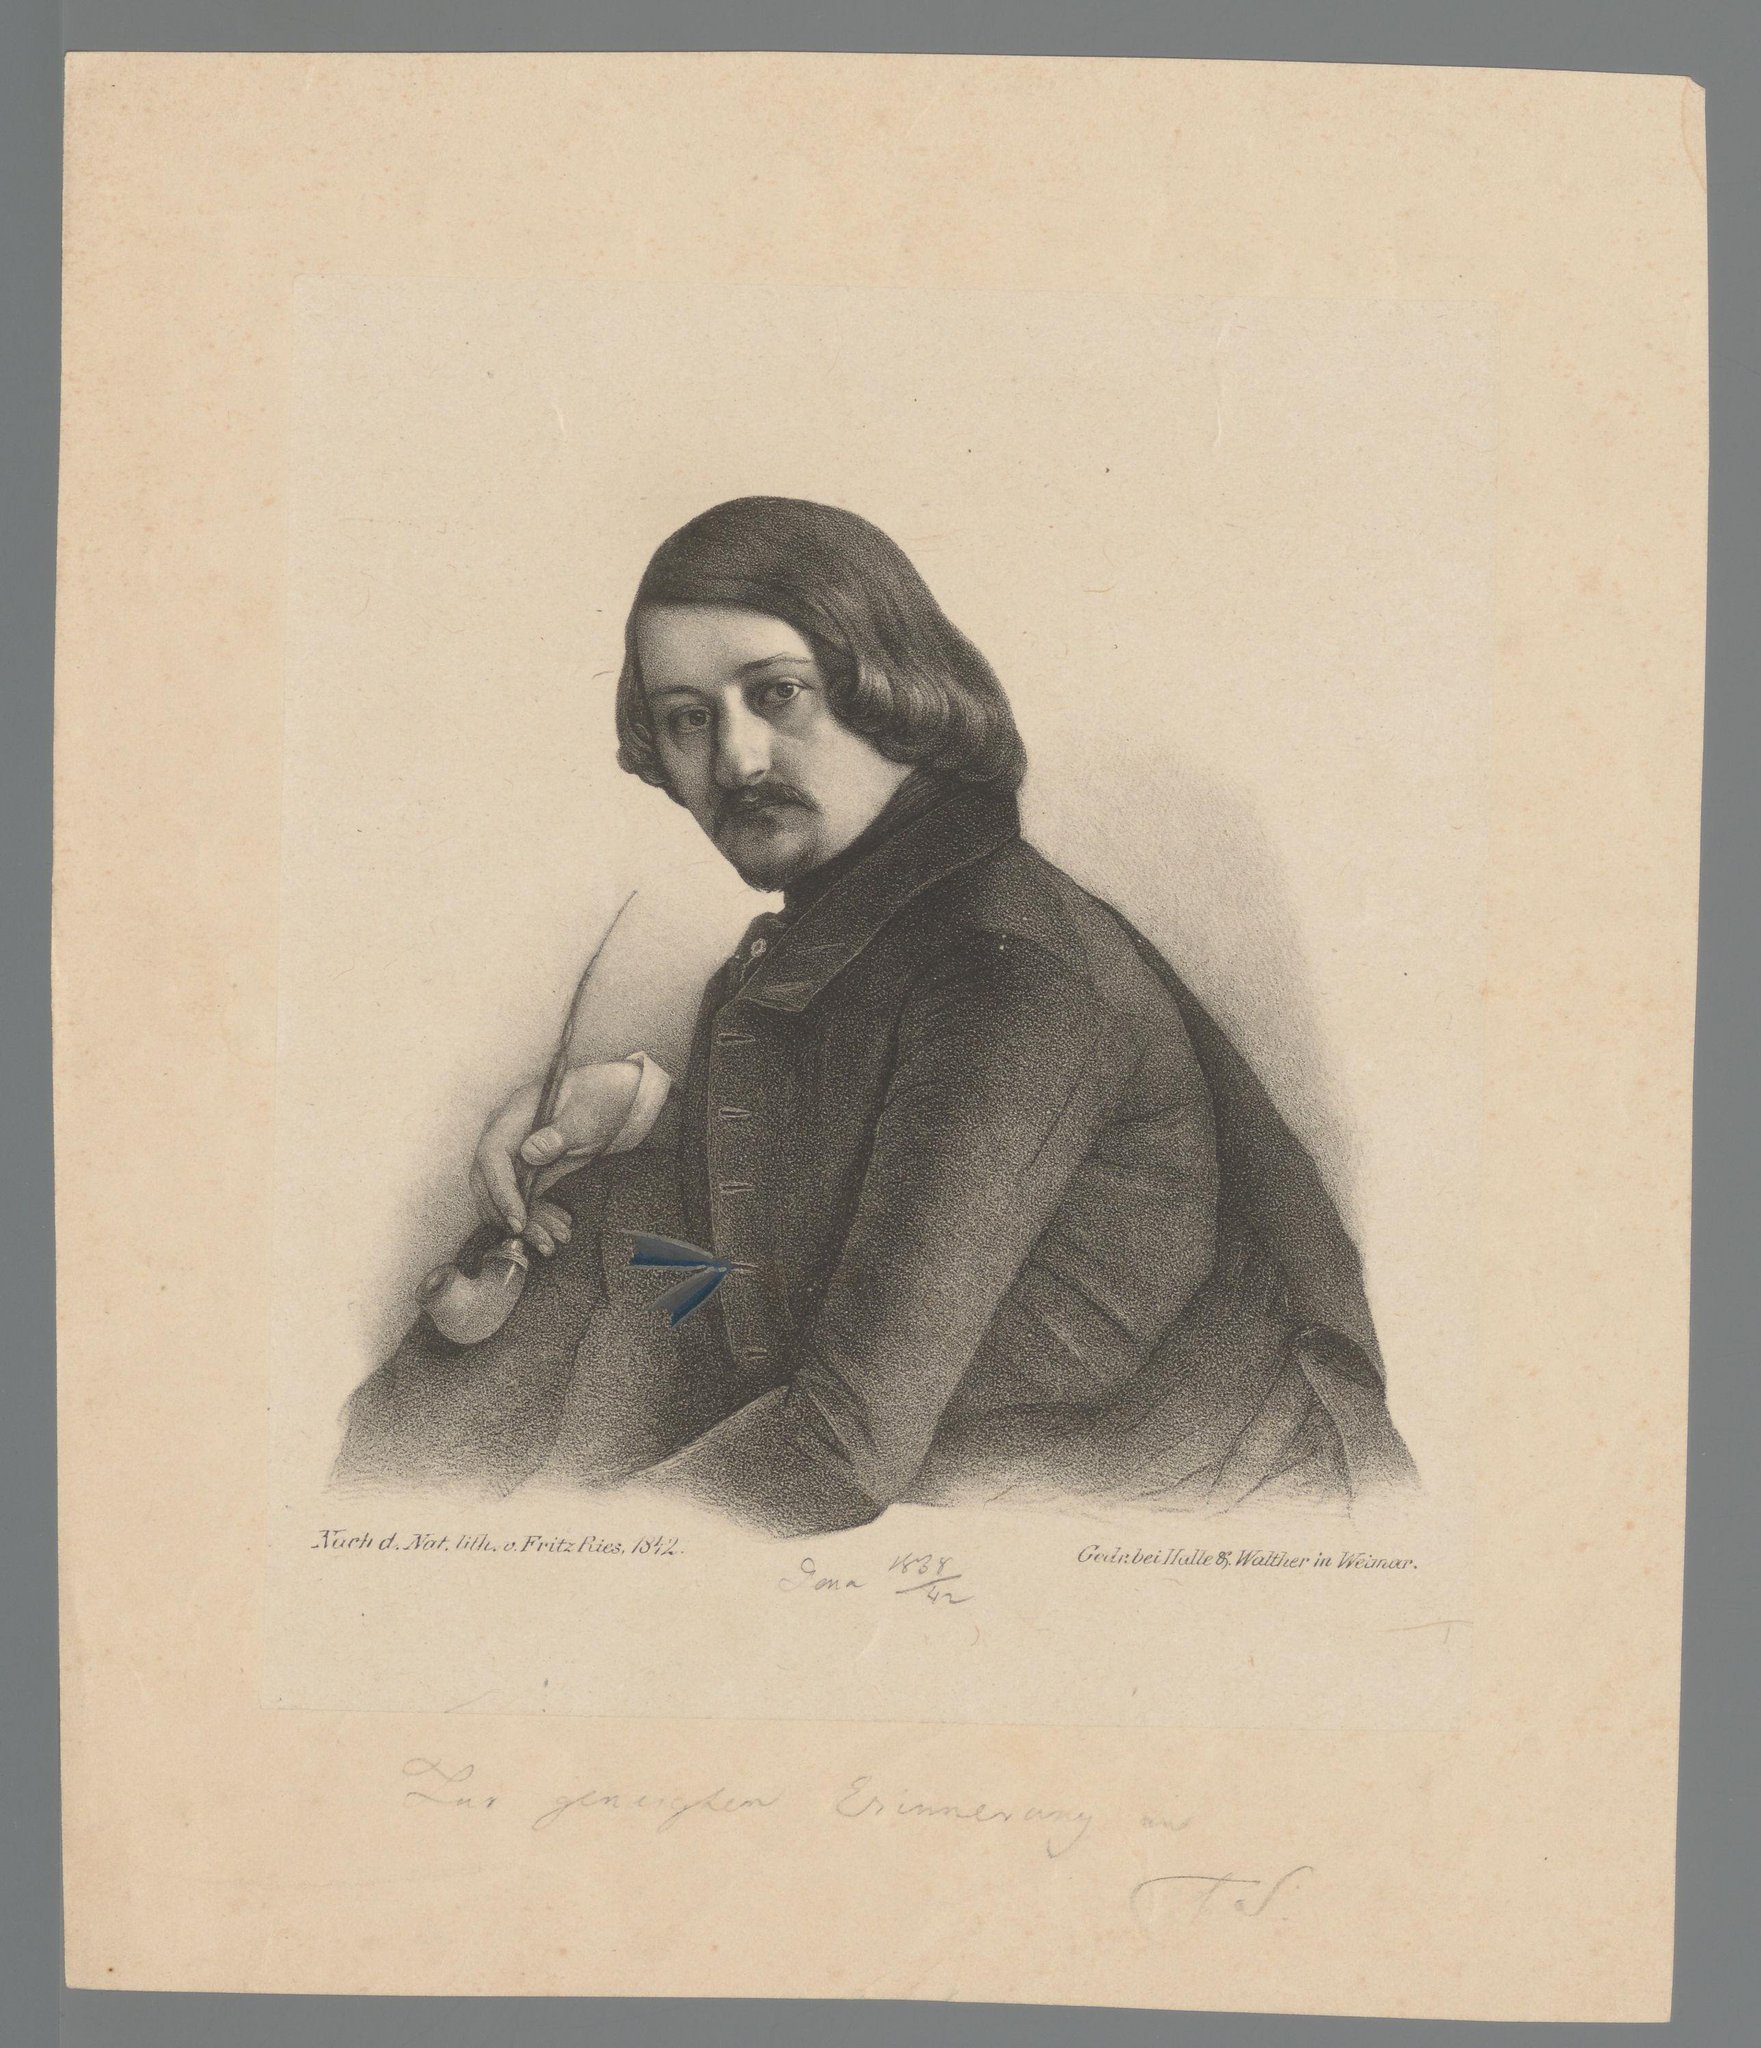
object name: print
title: Portret van Ferdinand Schröder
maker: fritz ries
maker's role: print maker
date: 1842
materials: paper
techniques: hand coloring, lithograph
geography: weimar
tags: politician, historical persons, physician, doctor, politician, e.g. party leader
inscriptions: collector's mark: Lugt 2228